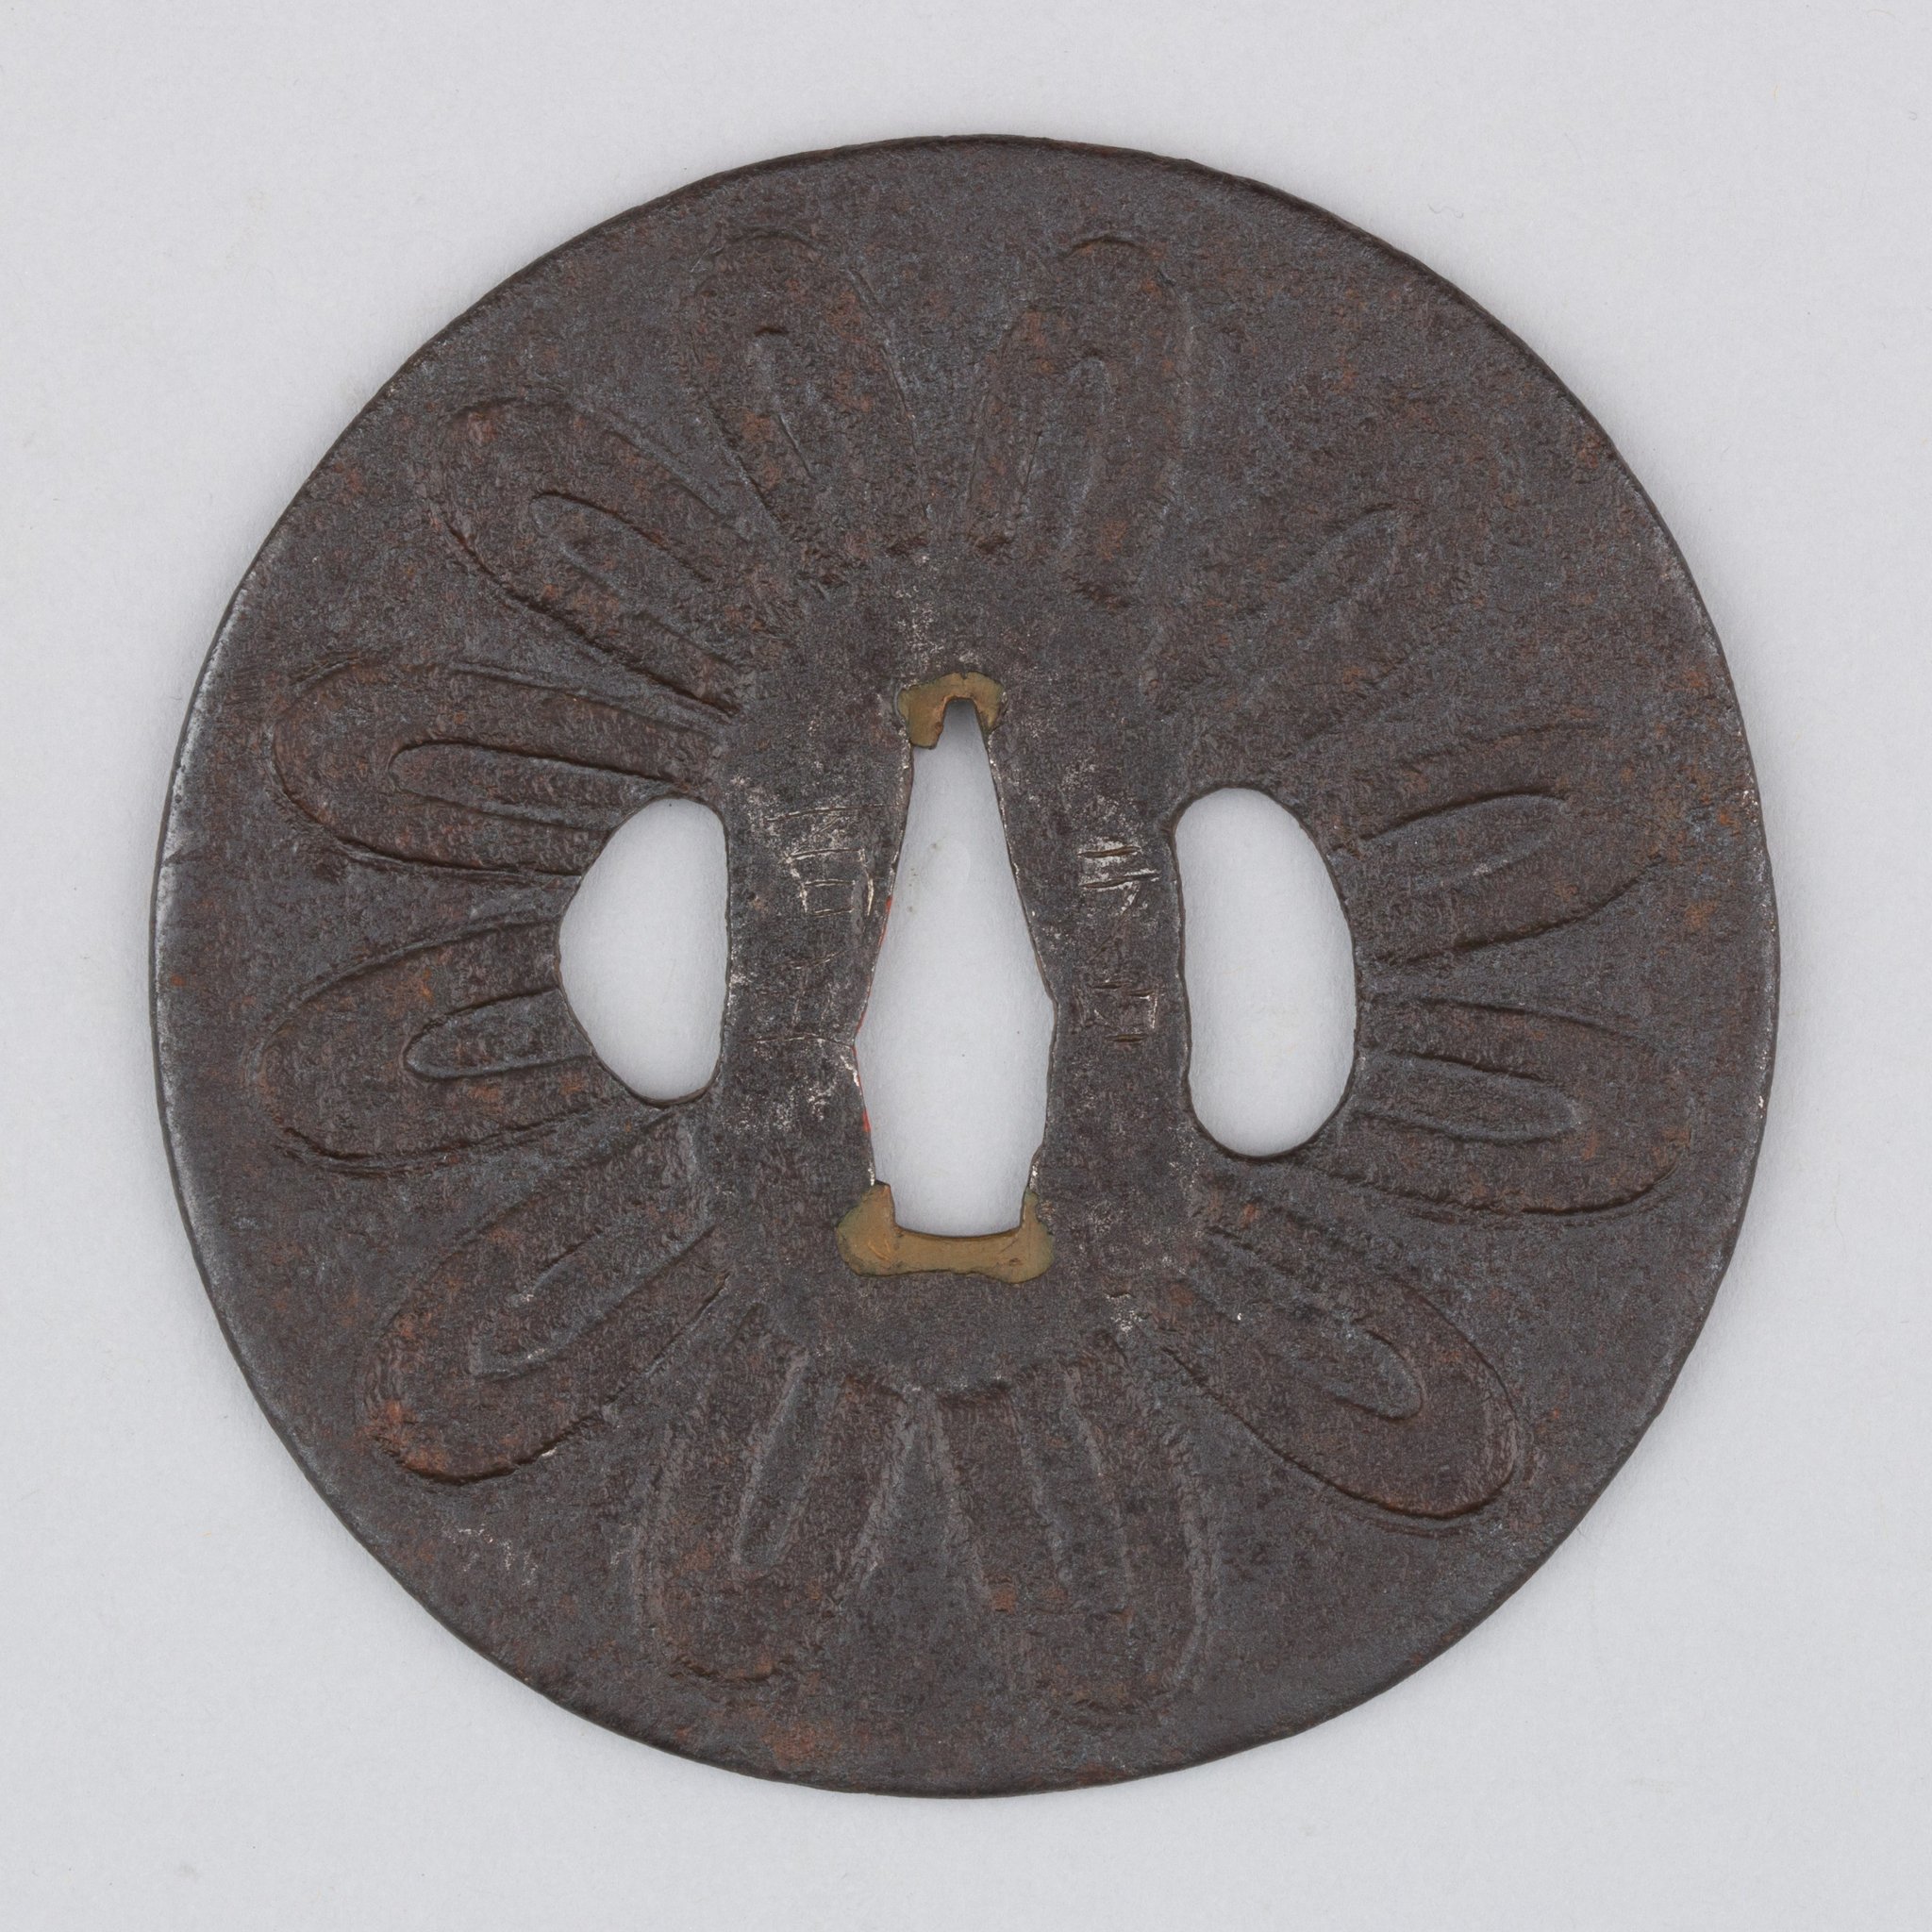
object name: sword guard tsuba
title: Sword Guard (Tsuba)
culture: japanese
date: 1500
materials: copper, iron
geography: japan